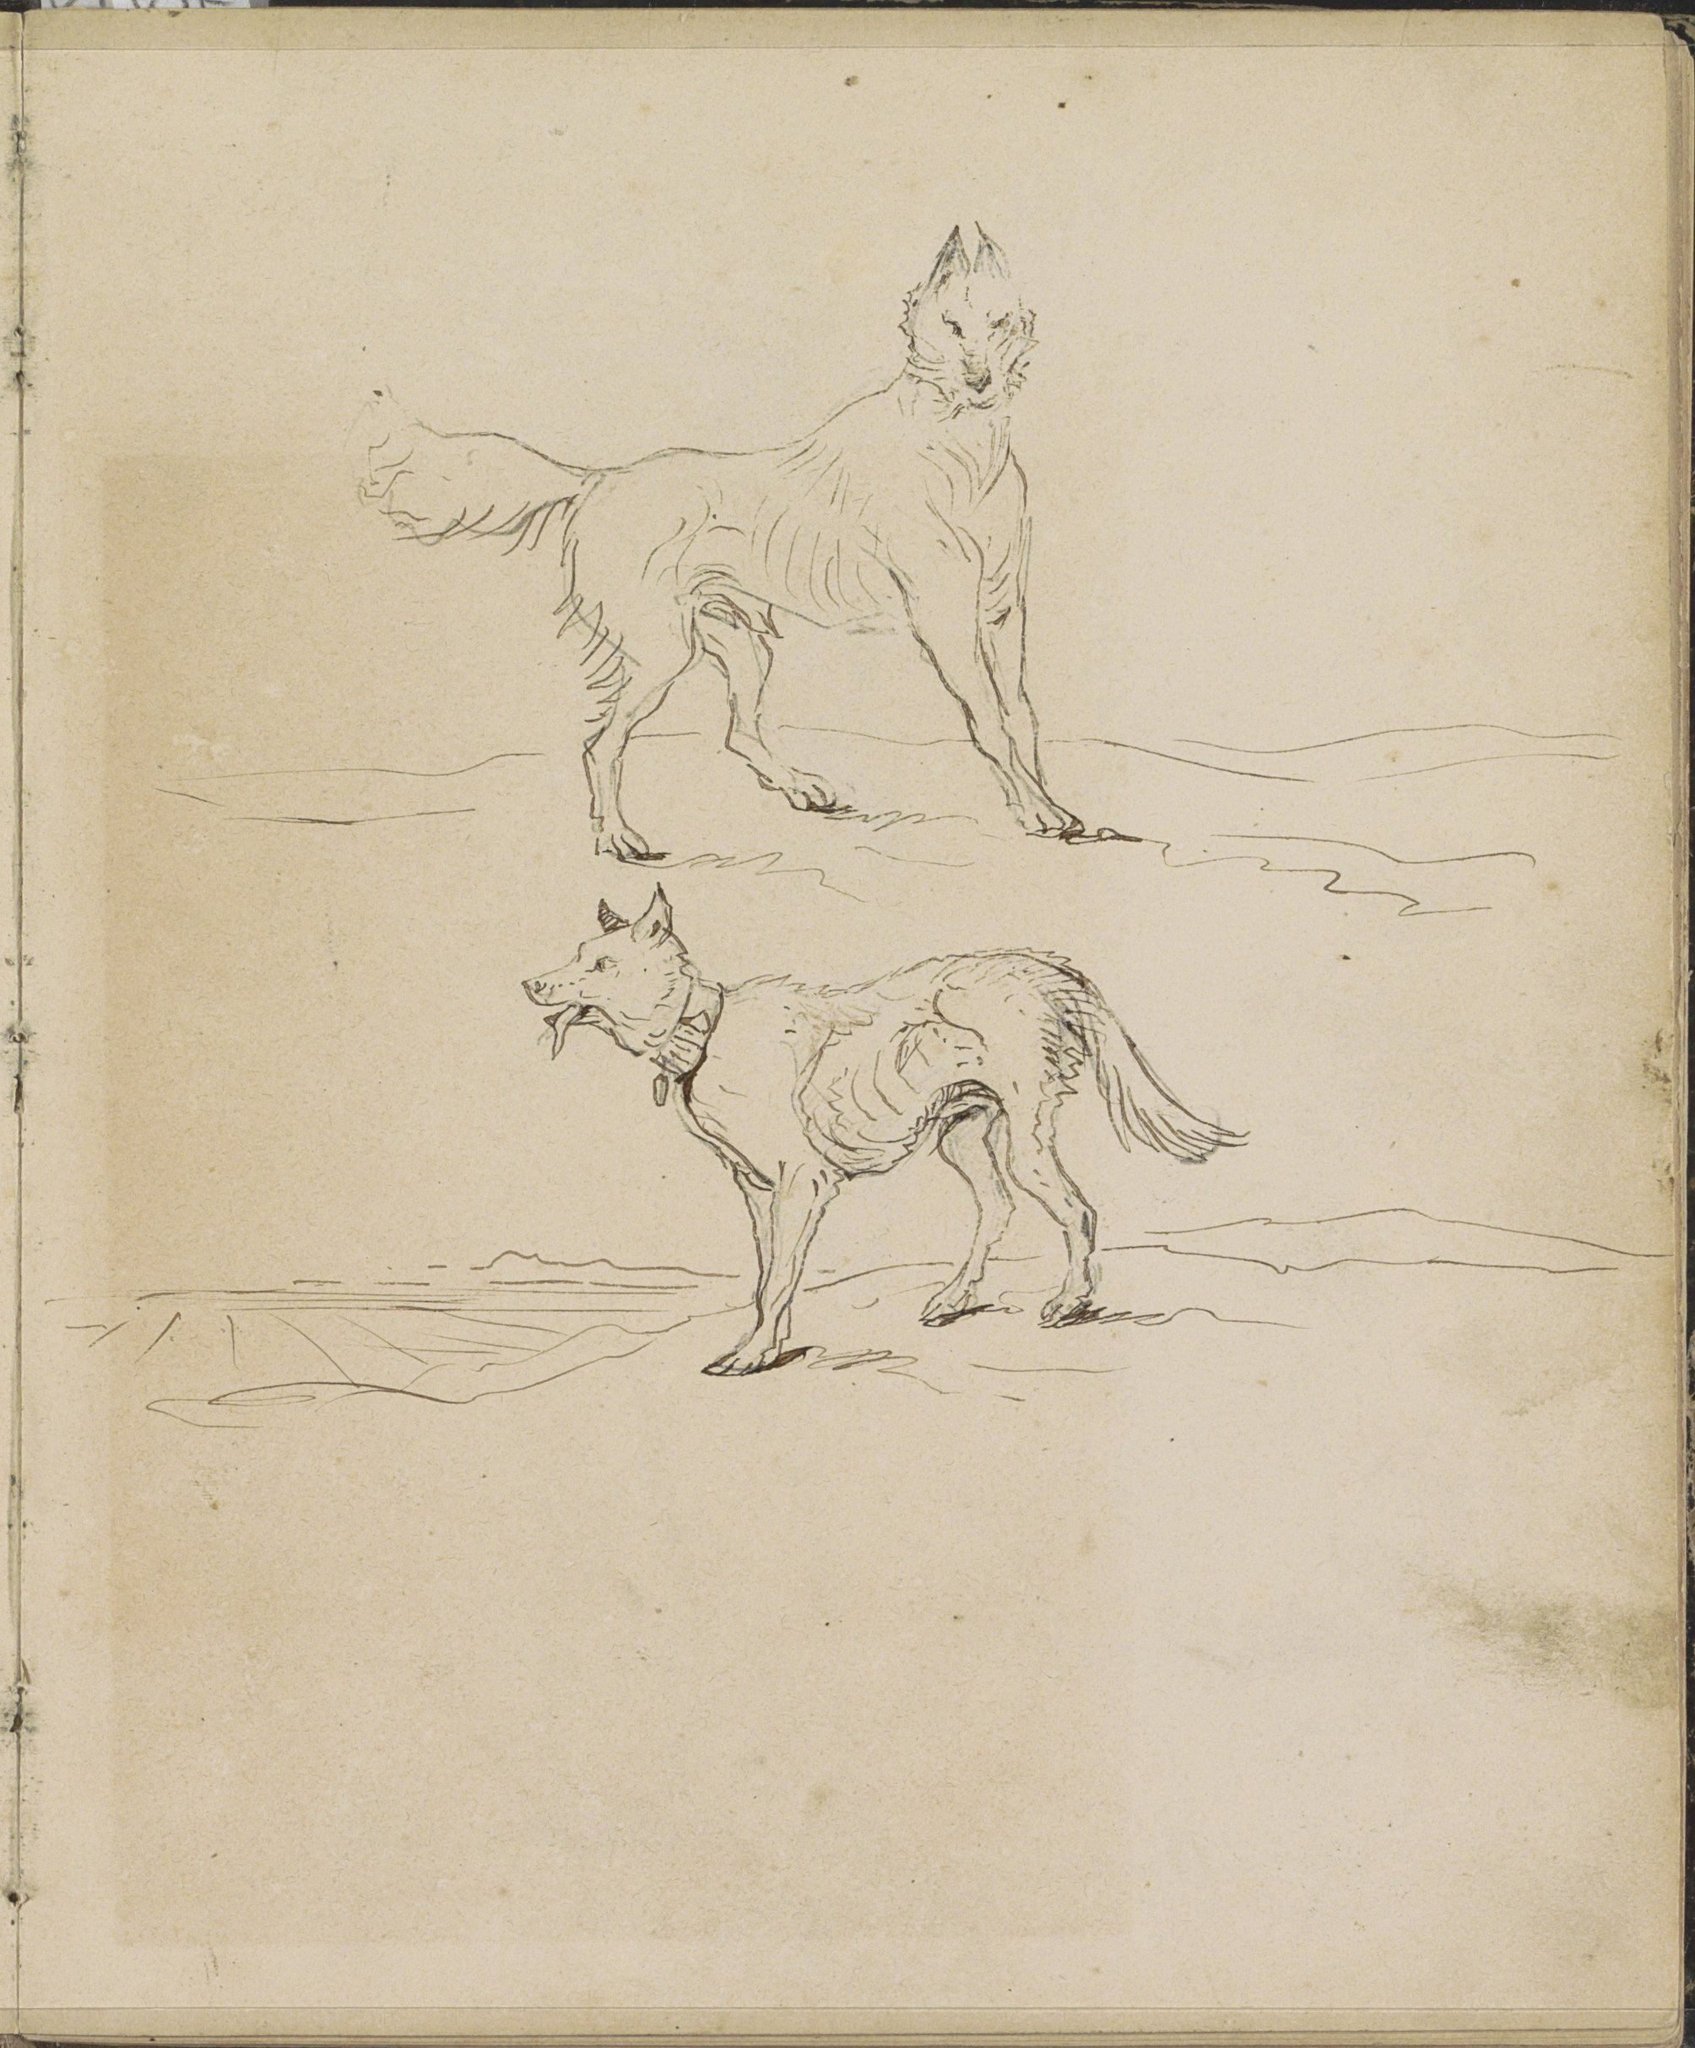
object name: sketchbook leaf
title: Honden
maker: johannes tavenraat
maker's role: draughtsman, painter, print maker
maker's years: 1809-1881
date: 1841-1853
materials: ink, paper, pencil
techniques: pen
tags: dog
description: Blad 4 recto uit een schetsboek met 87 bladen.